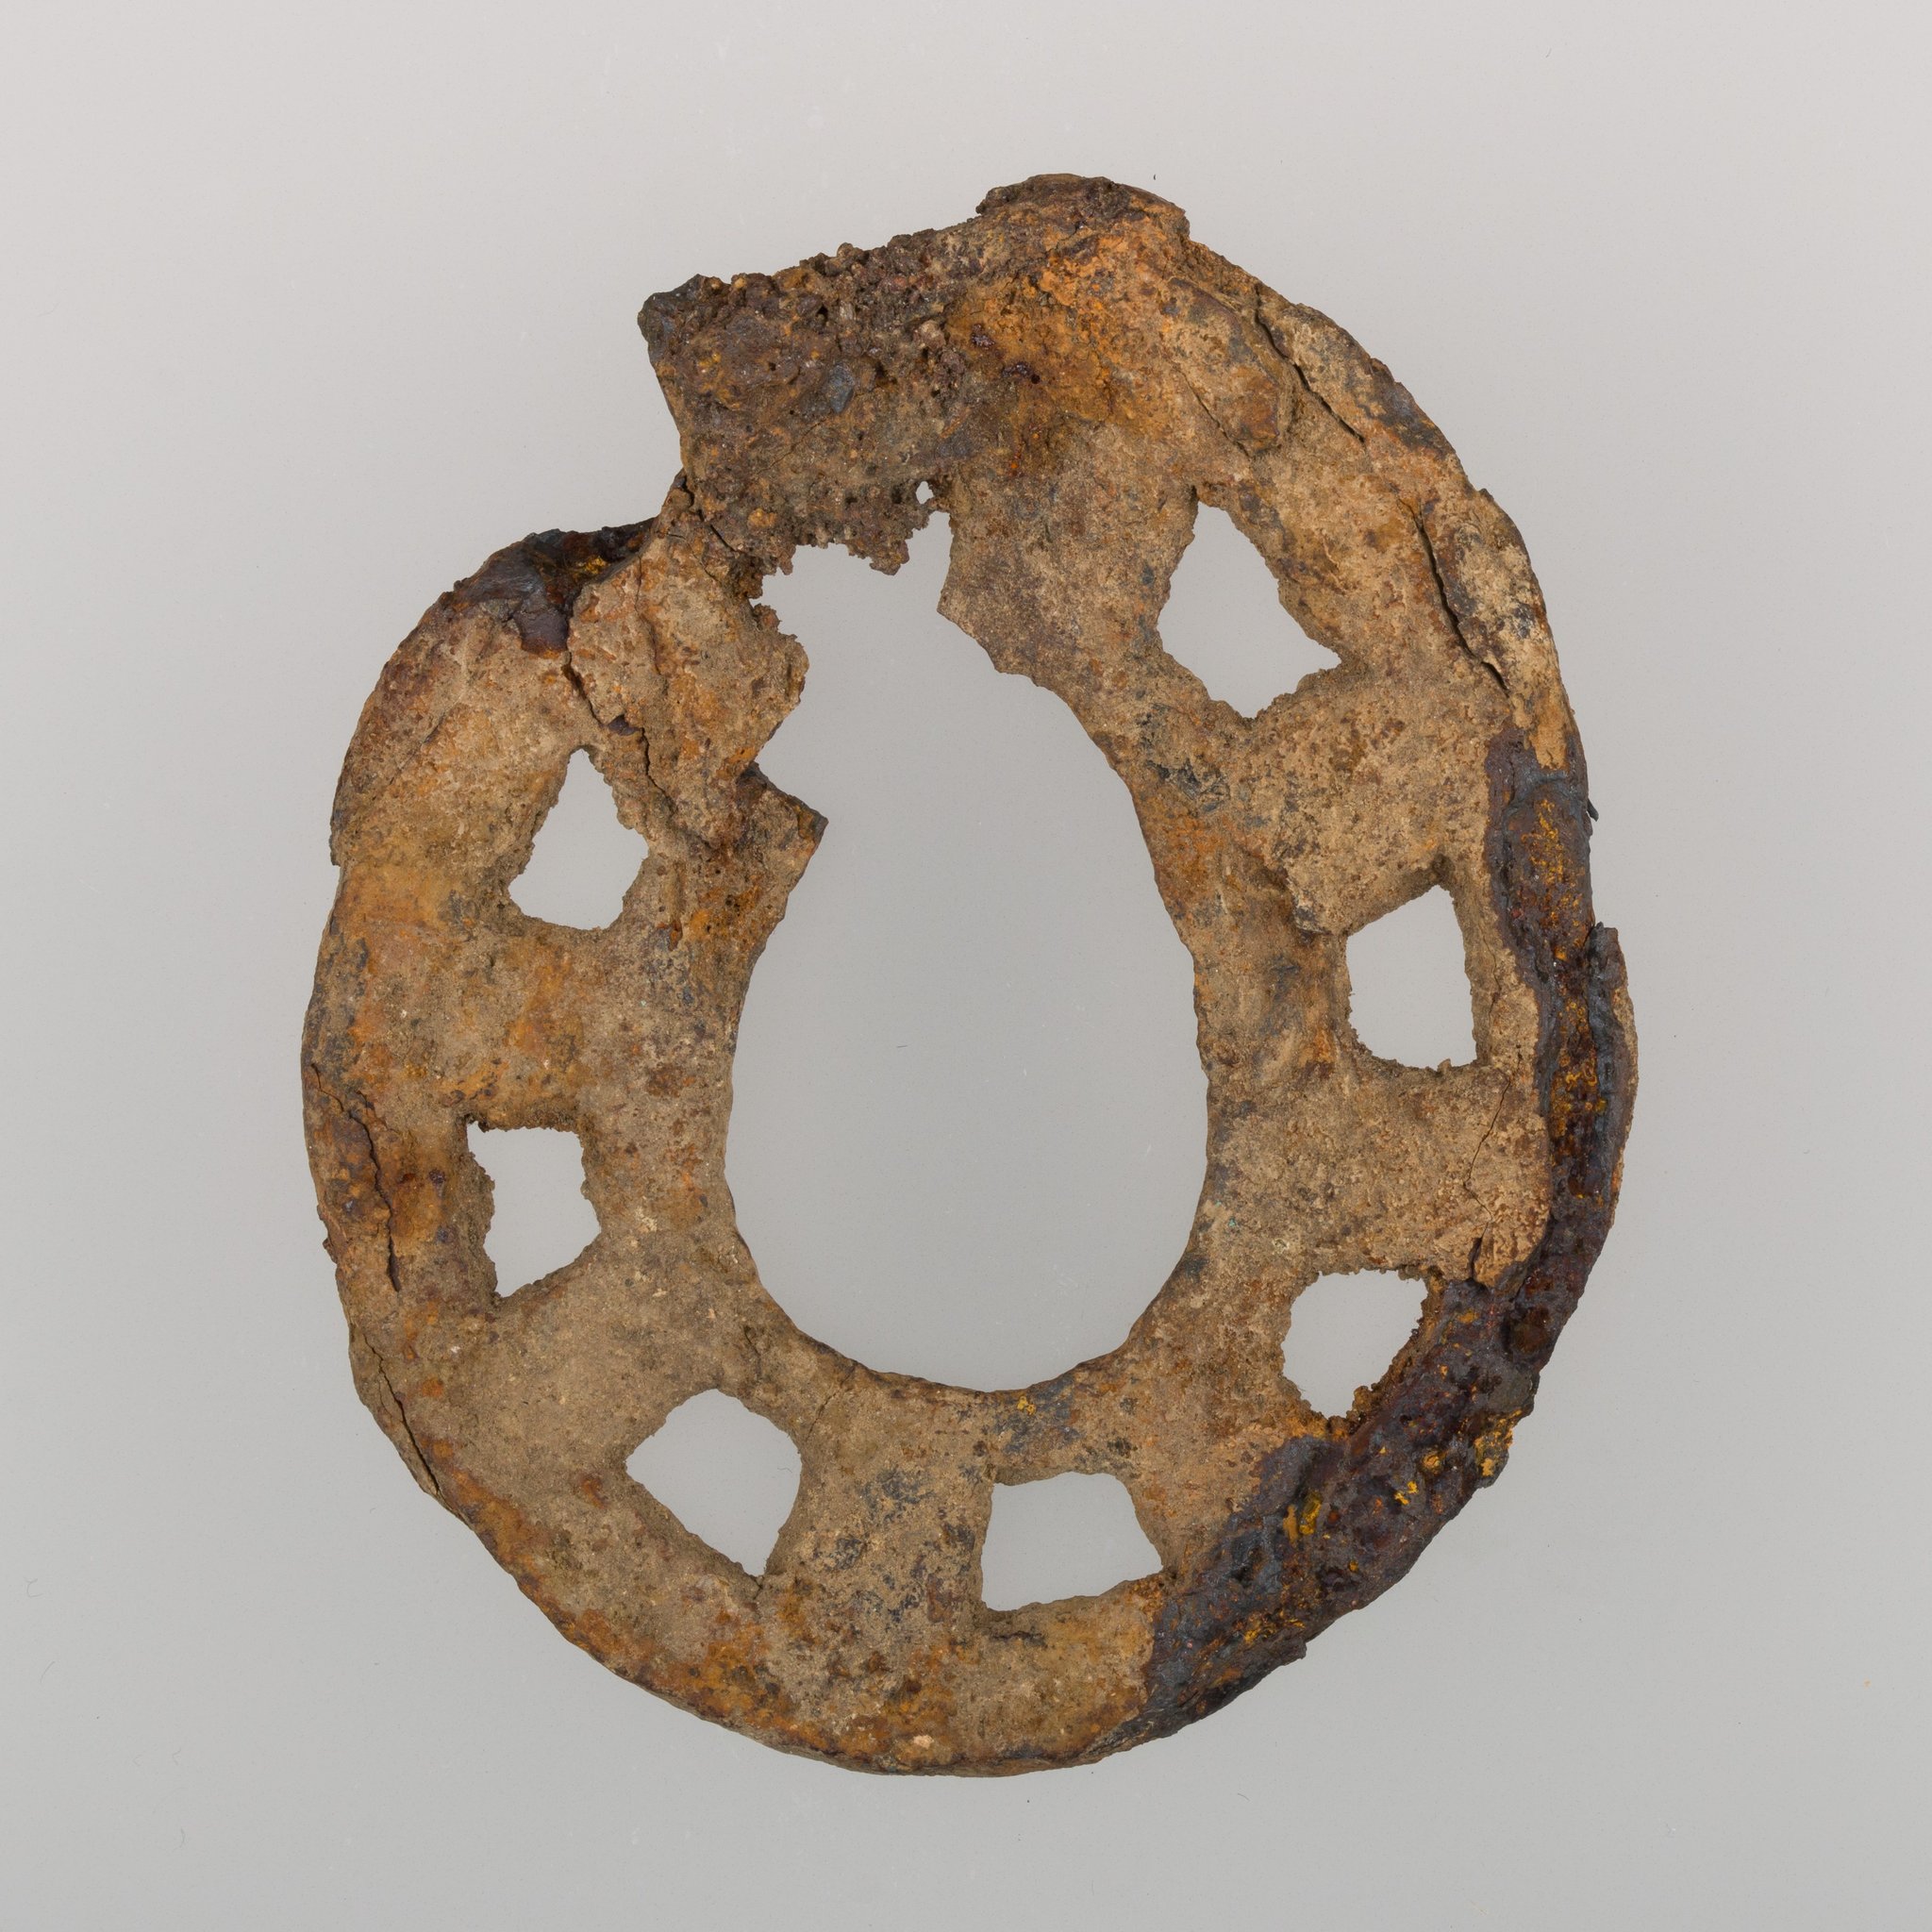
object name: sword guard tsuba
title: Sword Guard (Tsuba)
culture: japanese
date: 201-300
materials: iron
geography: japan